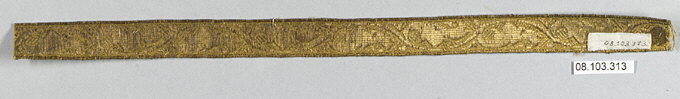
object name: galloon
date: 1601-1800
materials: silk